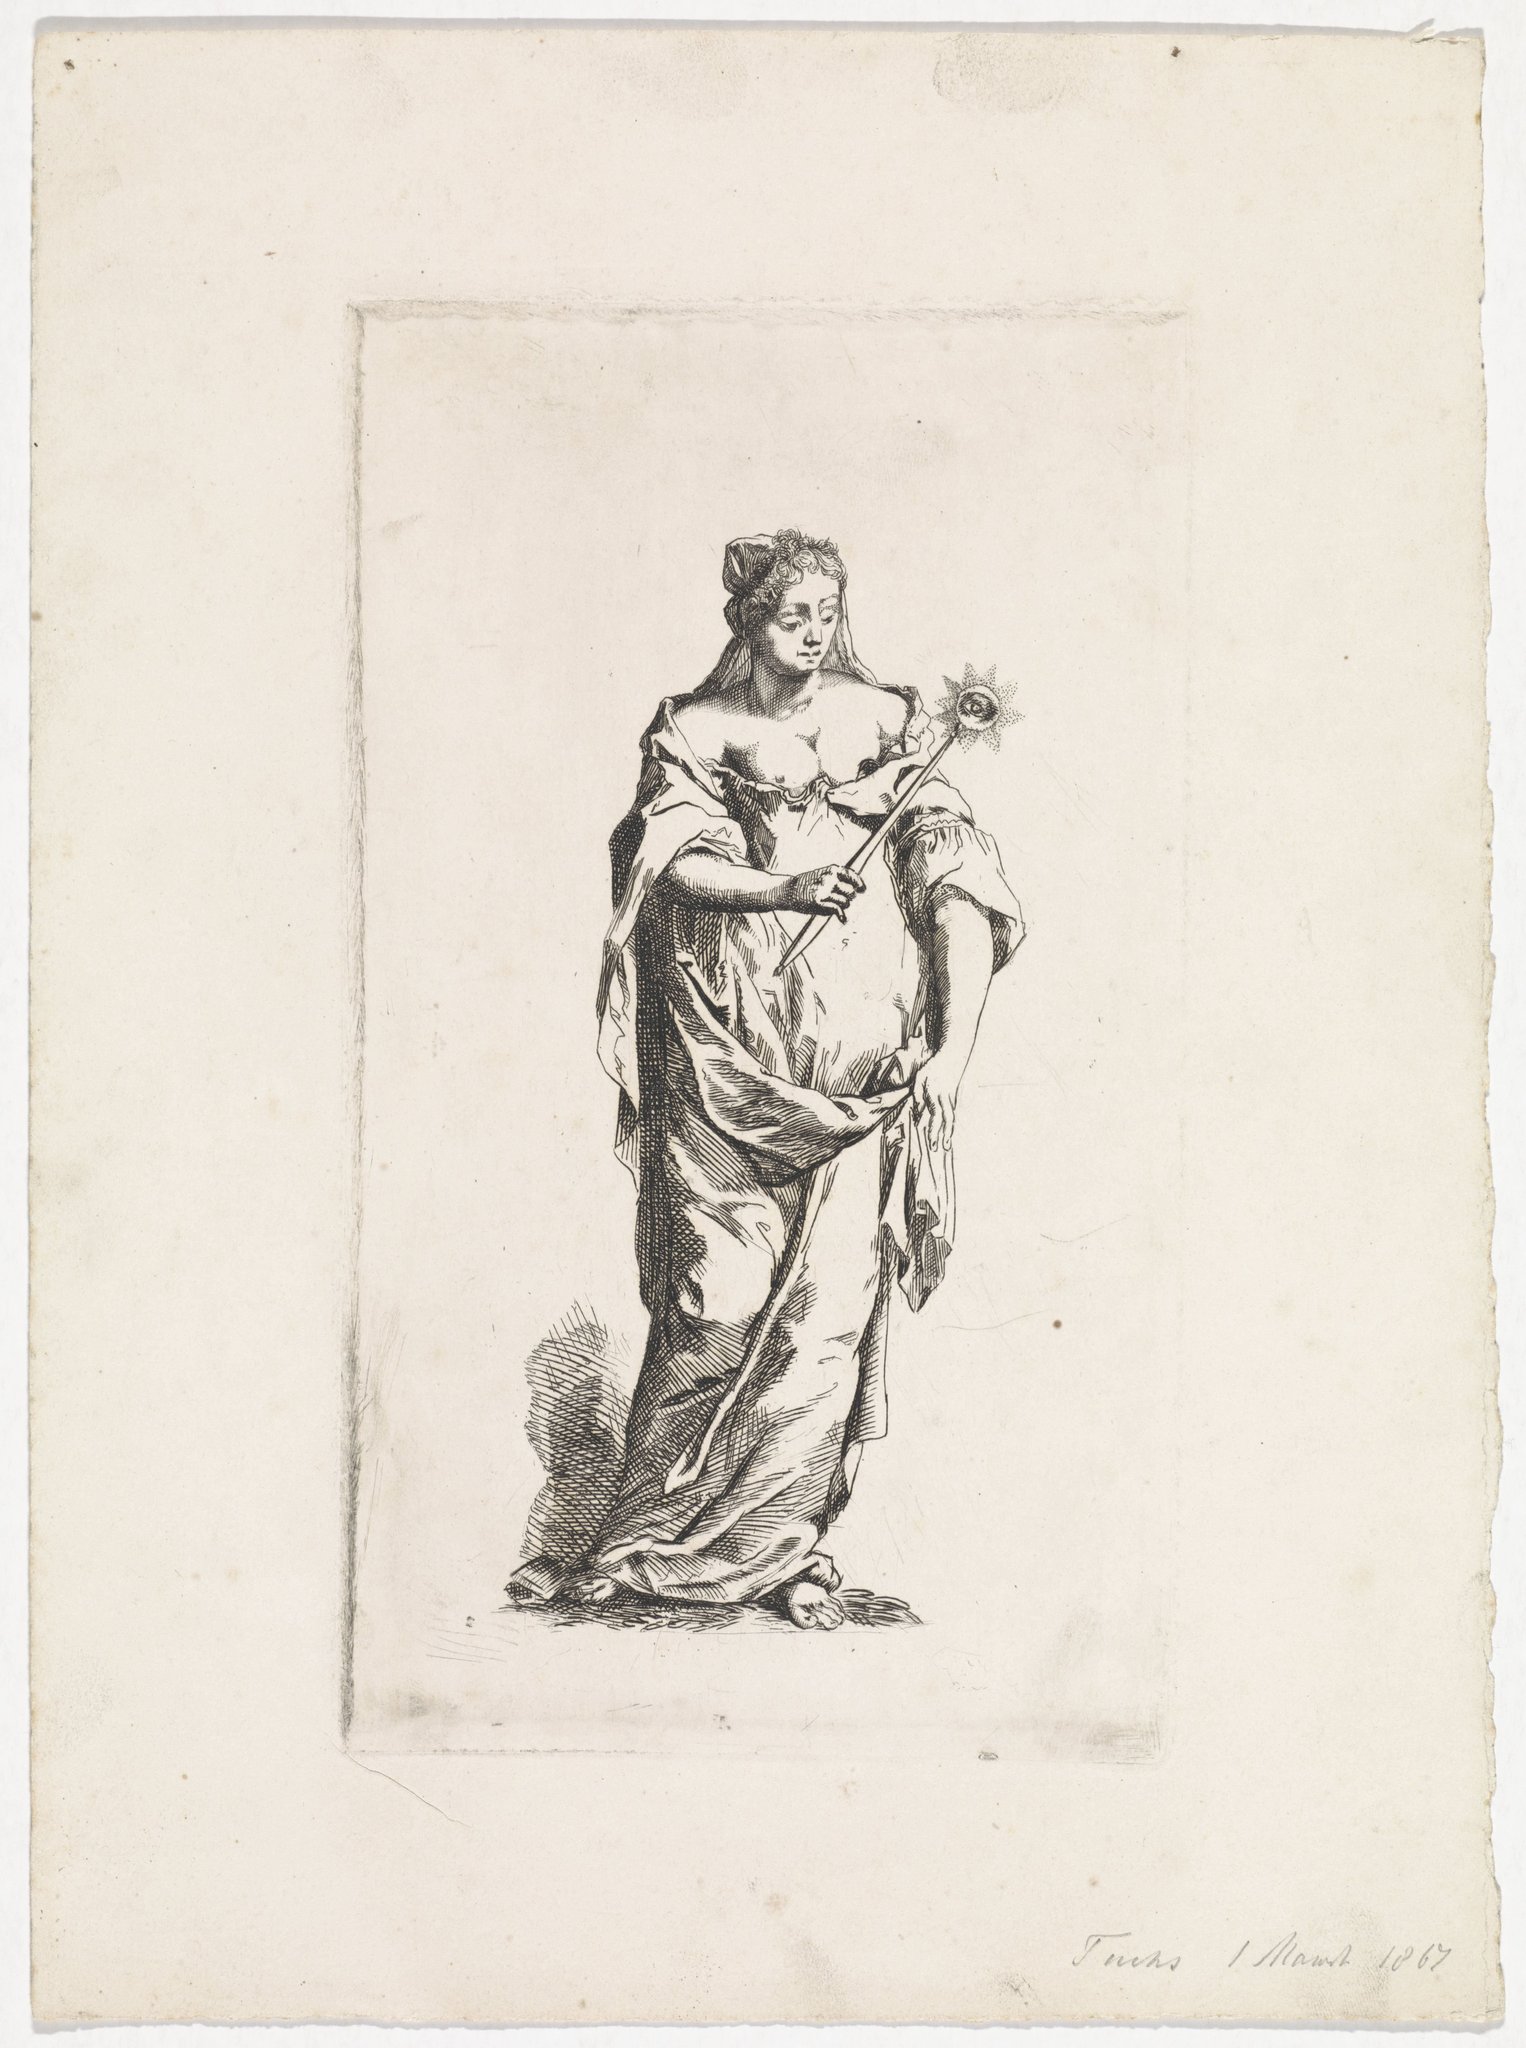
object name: print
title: Personificatie van de zedigheid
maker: c.a. tuchs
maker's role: print maker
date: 1867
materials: paper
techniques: engraving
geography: netherlands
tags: the all-seeing eye, triangle with eye ~ symbol of god the father, discretion, modesty; 'discretione', 'modestia' (ripa)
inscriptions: inscription: ‘Tuchs 1 Maart 1867’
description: Een vrouwfiguur als personificatie van de zedigheid met in haar hand een staf met daarop het Alziend oog als symbool van God de Vader.